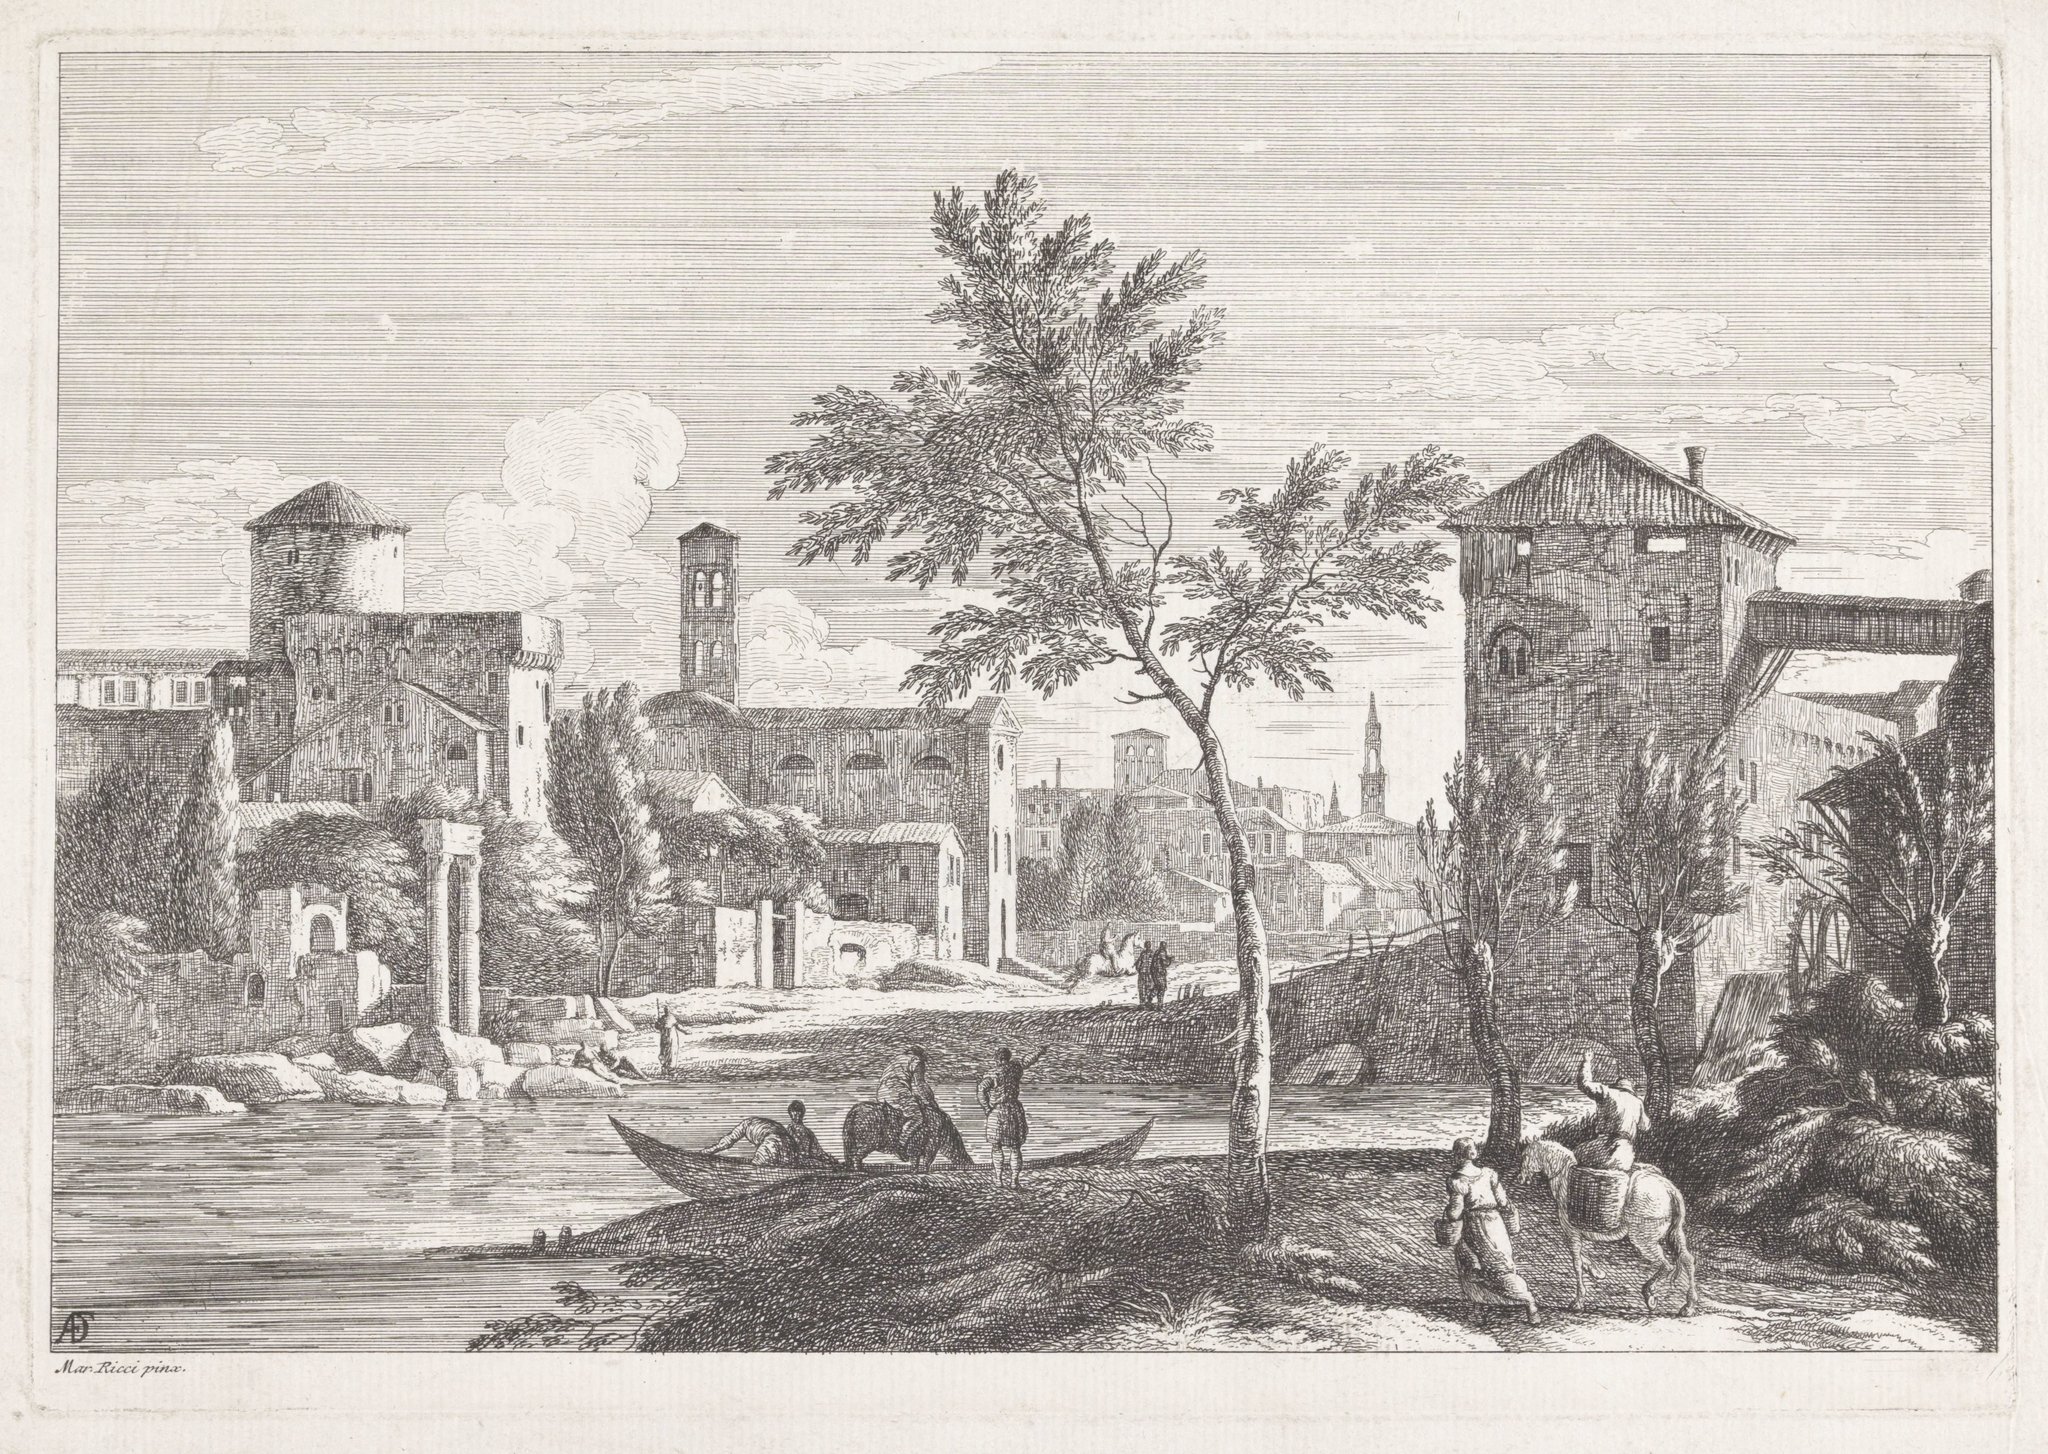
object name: print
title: Landschappen naar Marco Ricci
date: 1743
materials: paper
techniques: etching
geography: italy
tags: city-view, and landscape with man-made constructions, landscapes, river, ferry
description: Landschap met een stad aan een rivier. Op de voorgrond reizigers die de rivier oversteken met een kleine boot.